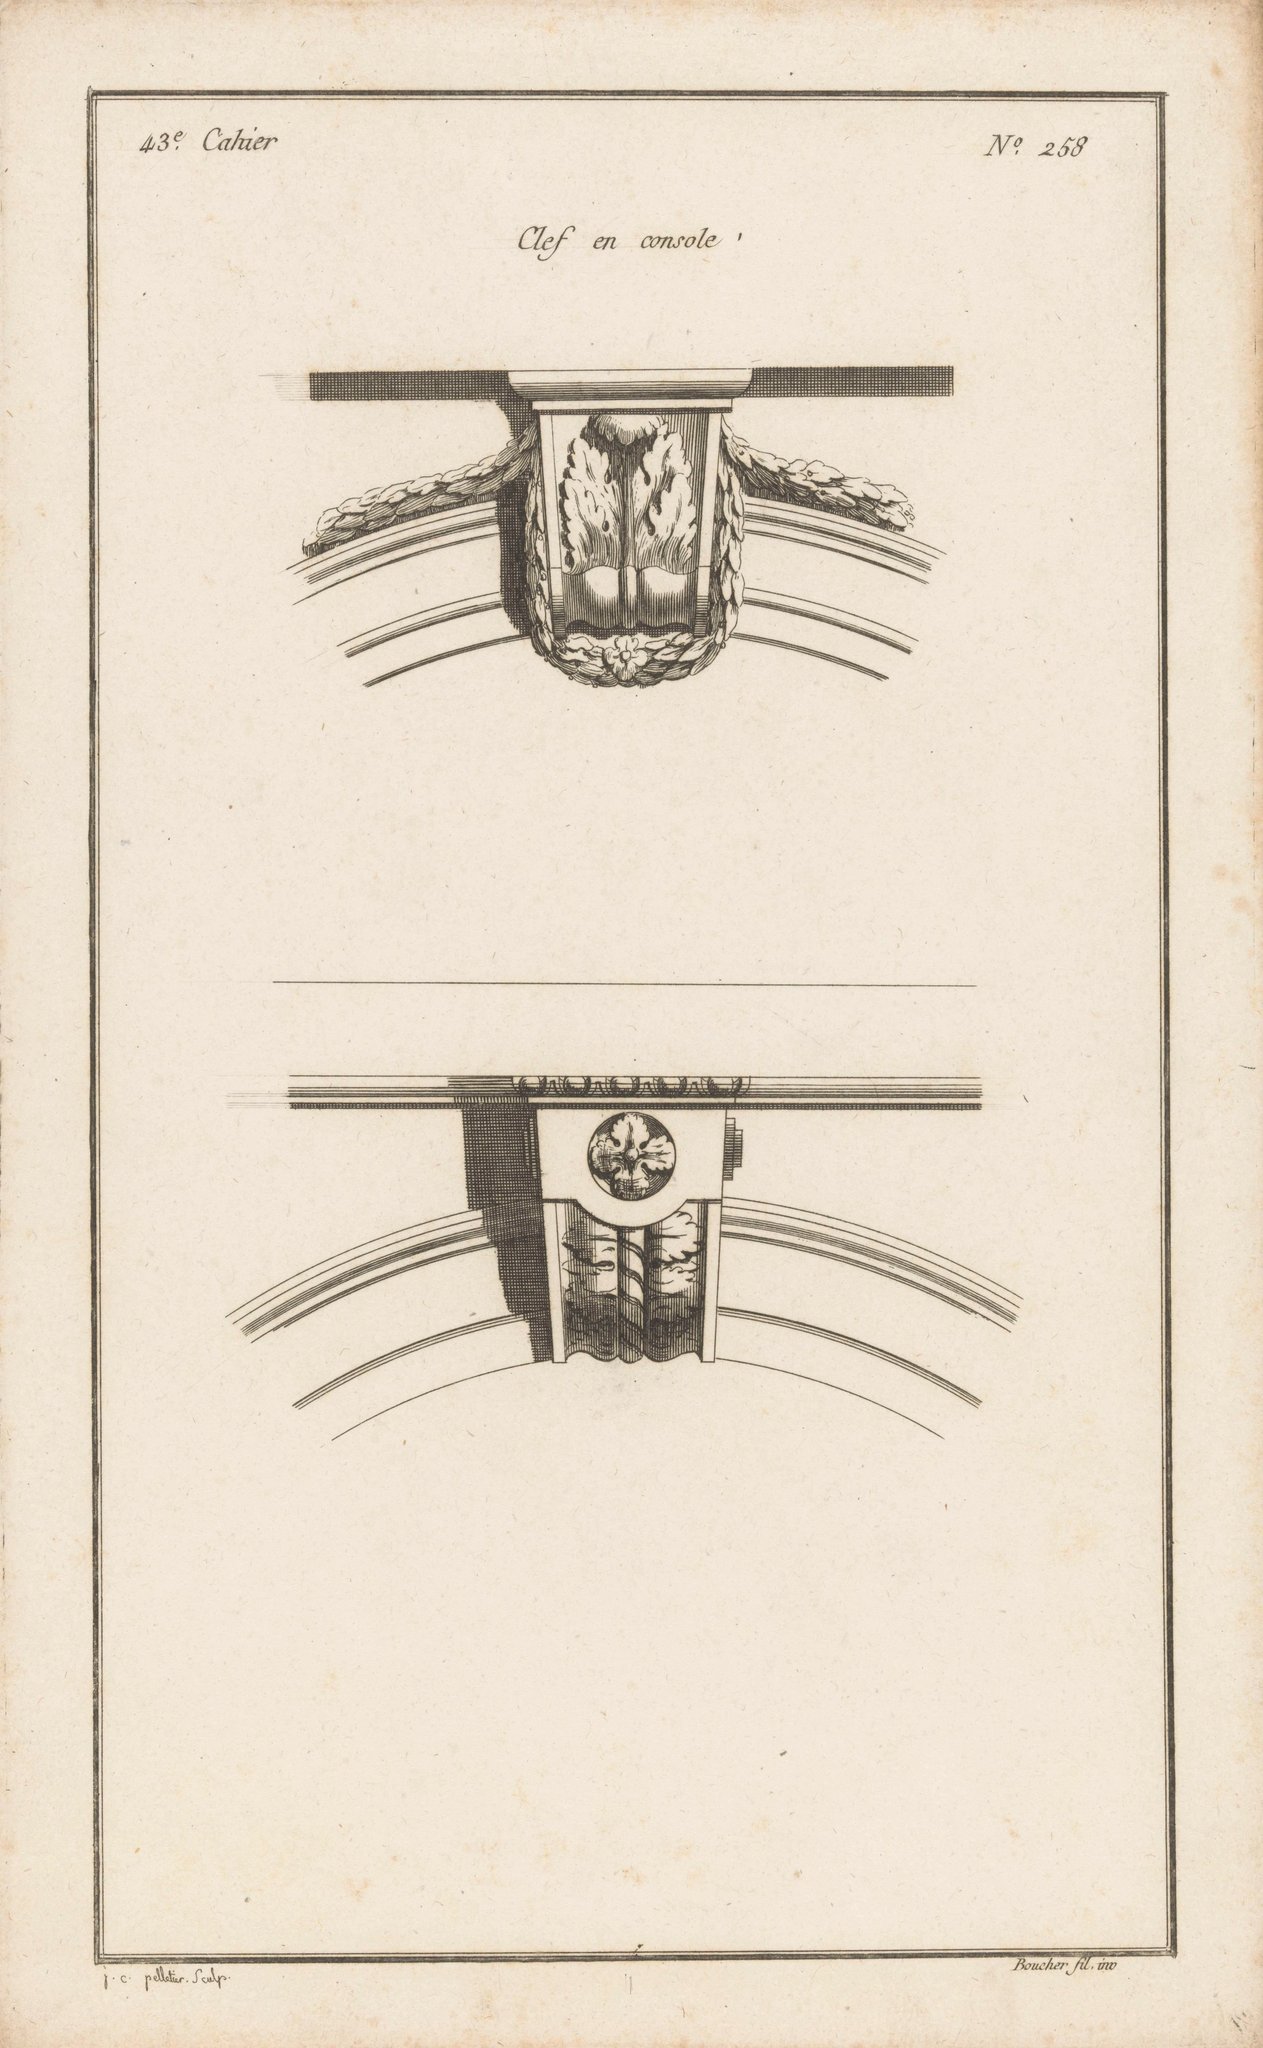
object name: ornament print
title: Sluitstenen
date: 1772-1779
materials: paper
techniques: engraving, etching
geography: paris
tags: foliage ~ ornament, keystone ~ architecture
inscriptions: collector's mark: Lugt 2760, collector's mark: Lugt 2228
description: Twee sluitstenen met bladmotieven. Prentnummer 258.